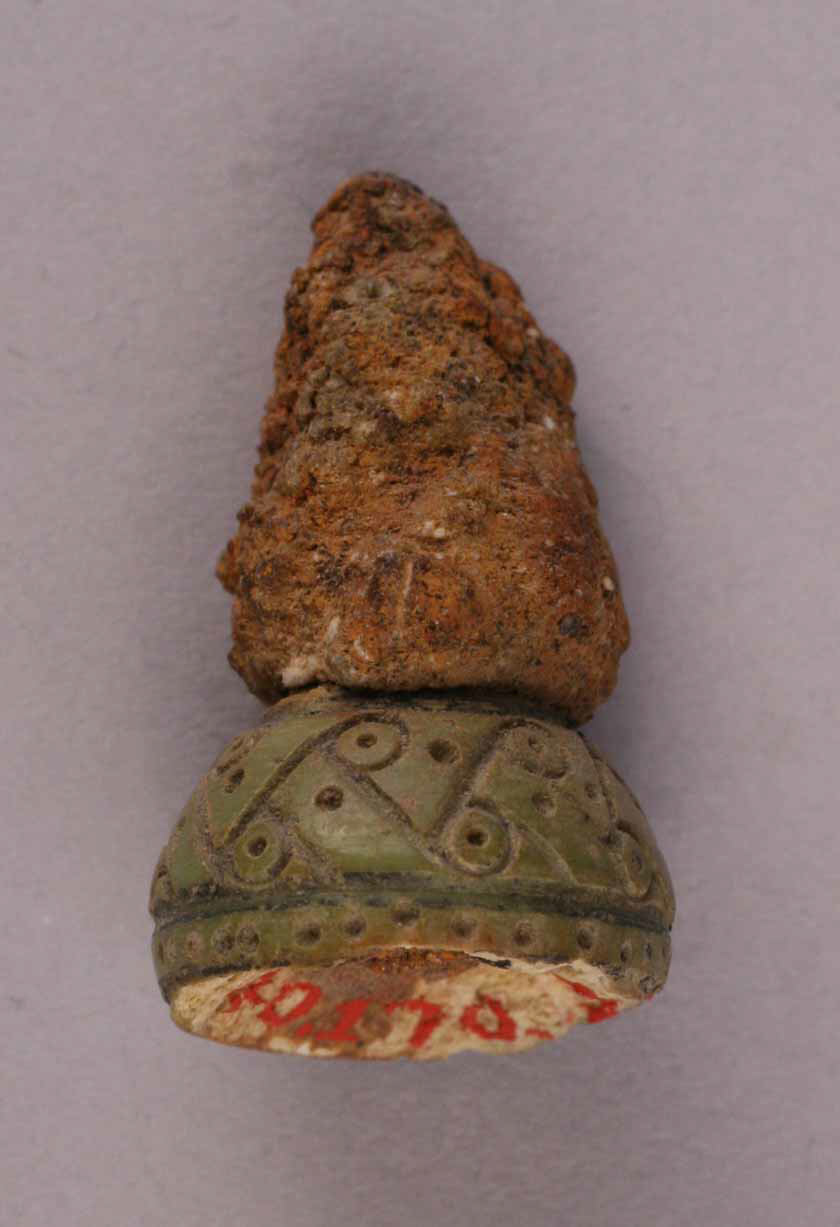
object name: button or bead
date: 801-1000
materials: bone, iron, paint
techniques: incising, inlay, tinting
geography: iran